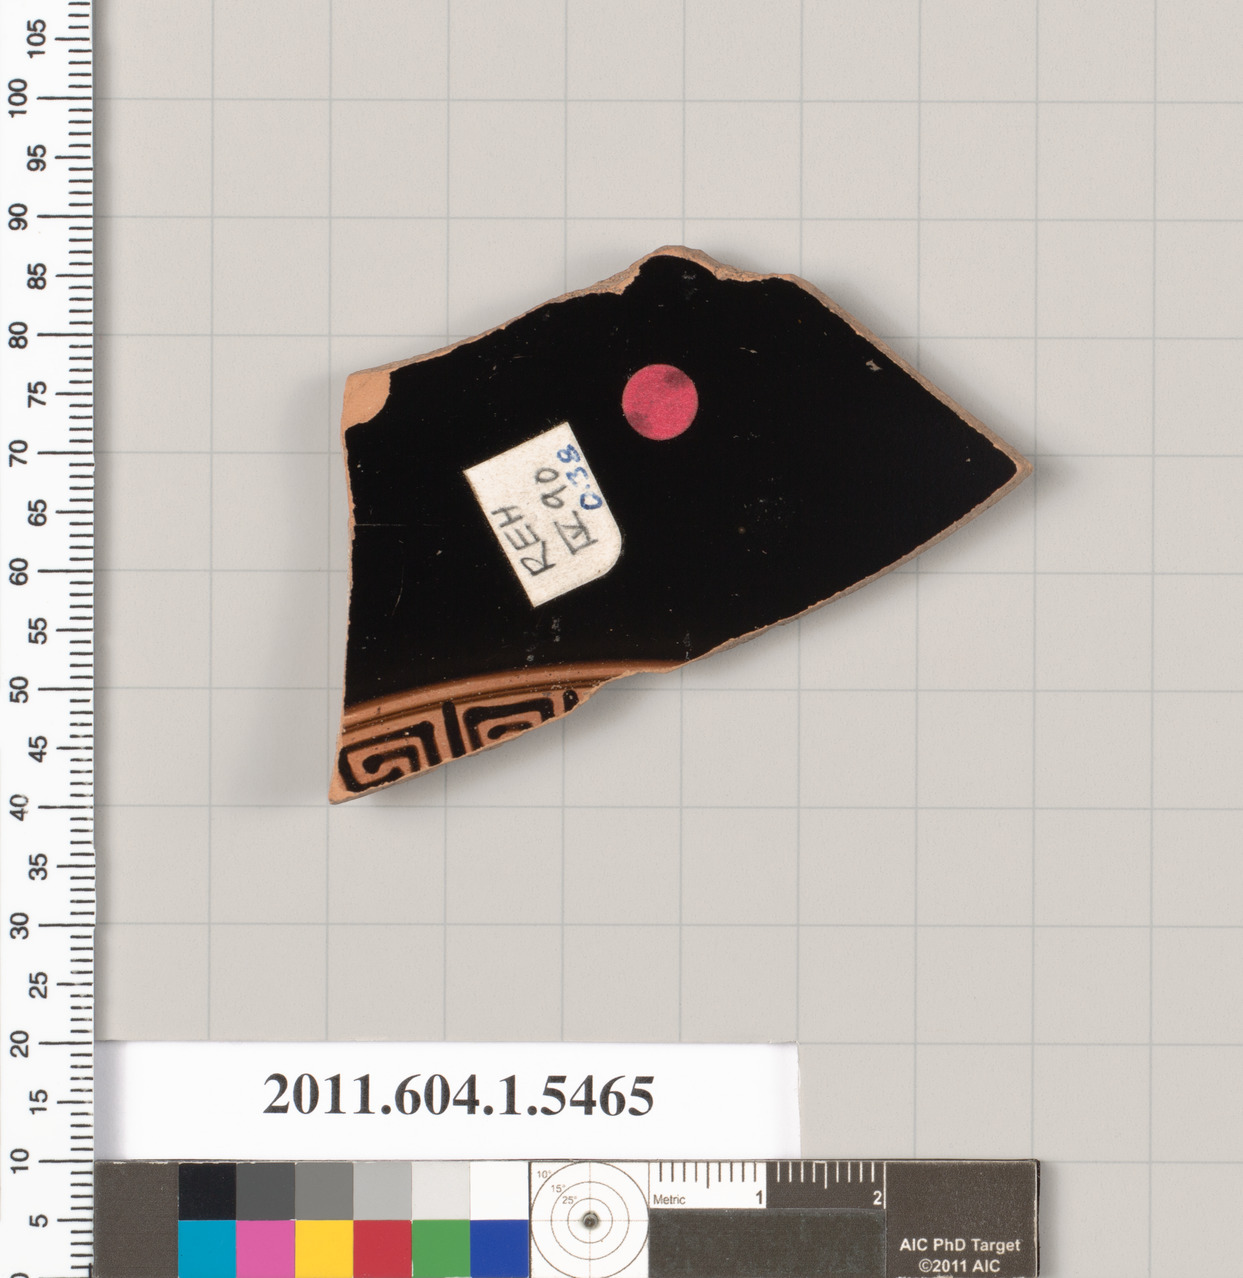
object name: kylix fragment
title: Terracotta fragment of a kylix (drinking cup)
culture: greek, attic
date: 510-500 BCE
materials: terracotta